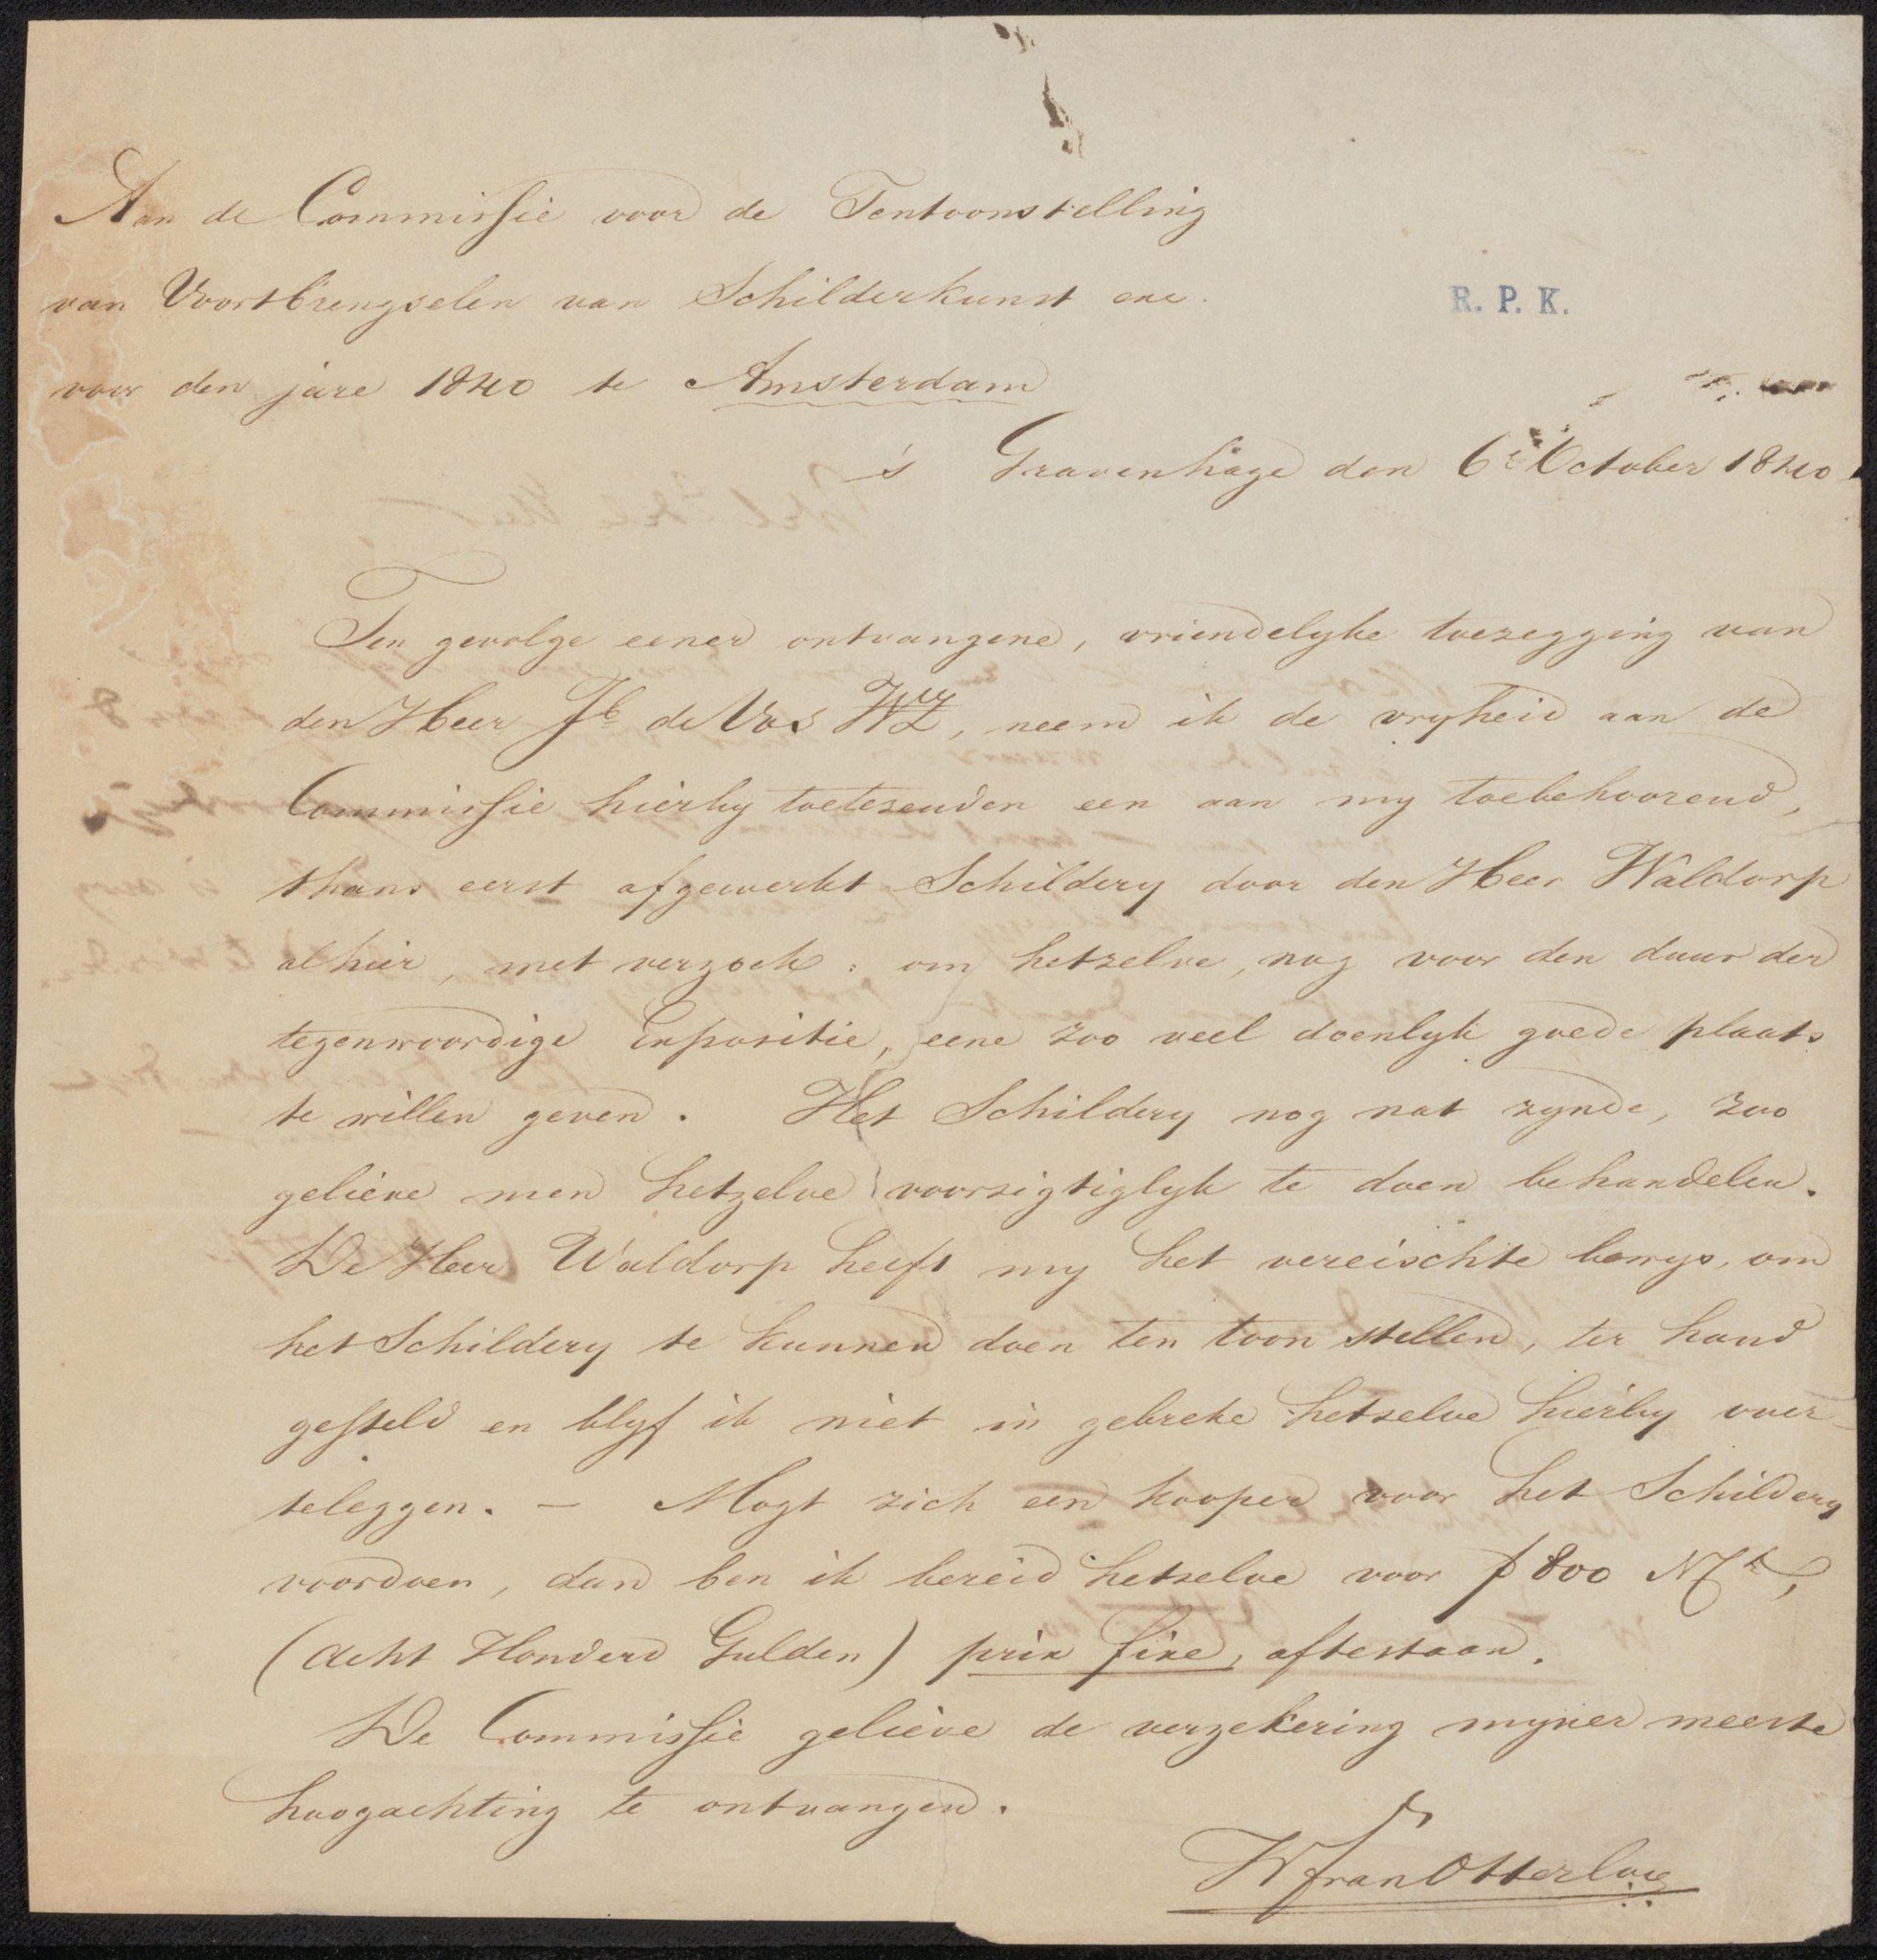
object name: letter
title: Brief aan de Commissie van de Tentoonstelling van Levende Meesters in Amsterdam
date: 1840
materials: ink, paper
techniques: pen, writing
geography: the hague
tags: w. f. van otterloo, the hague, amsterdam, painter, print maker, draughtsman, antonie waldorp, painting (including book-illumination, miniature-painting), exhibition ~ art, money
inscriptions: collector's mark: Lugt 2233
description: Brief bevat verso een brief van Antonie Waldorp aan W.F. van Otterloo.